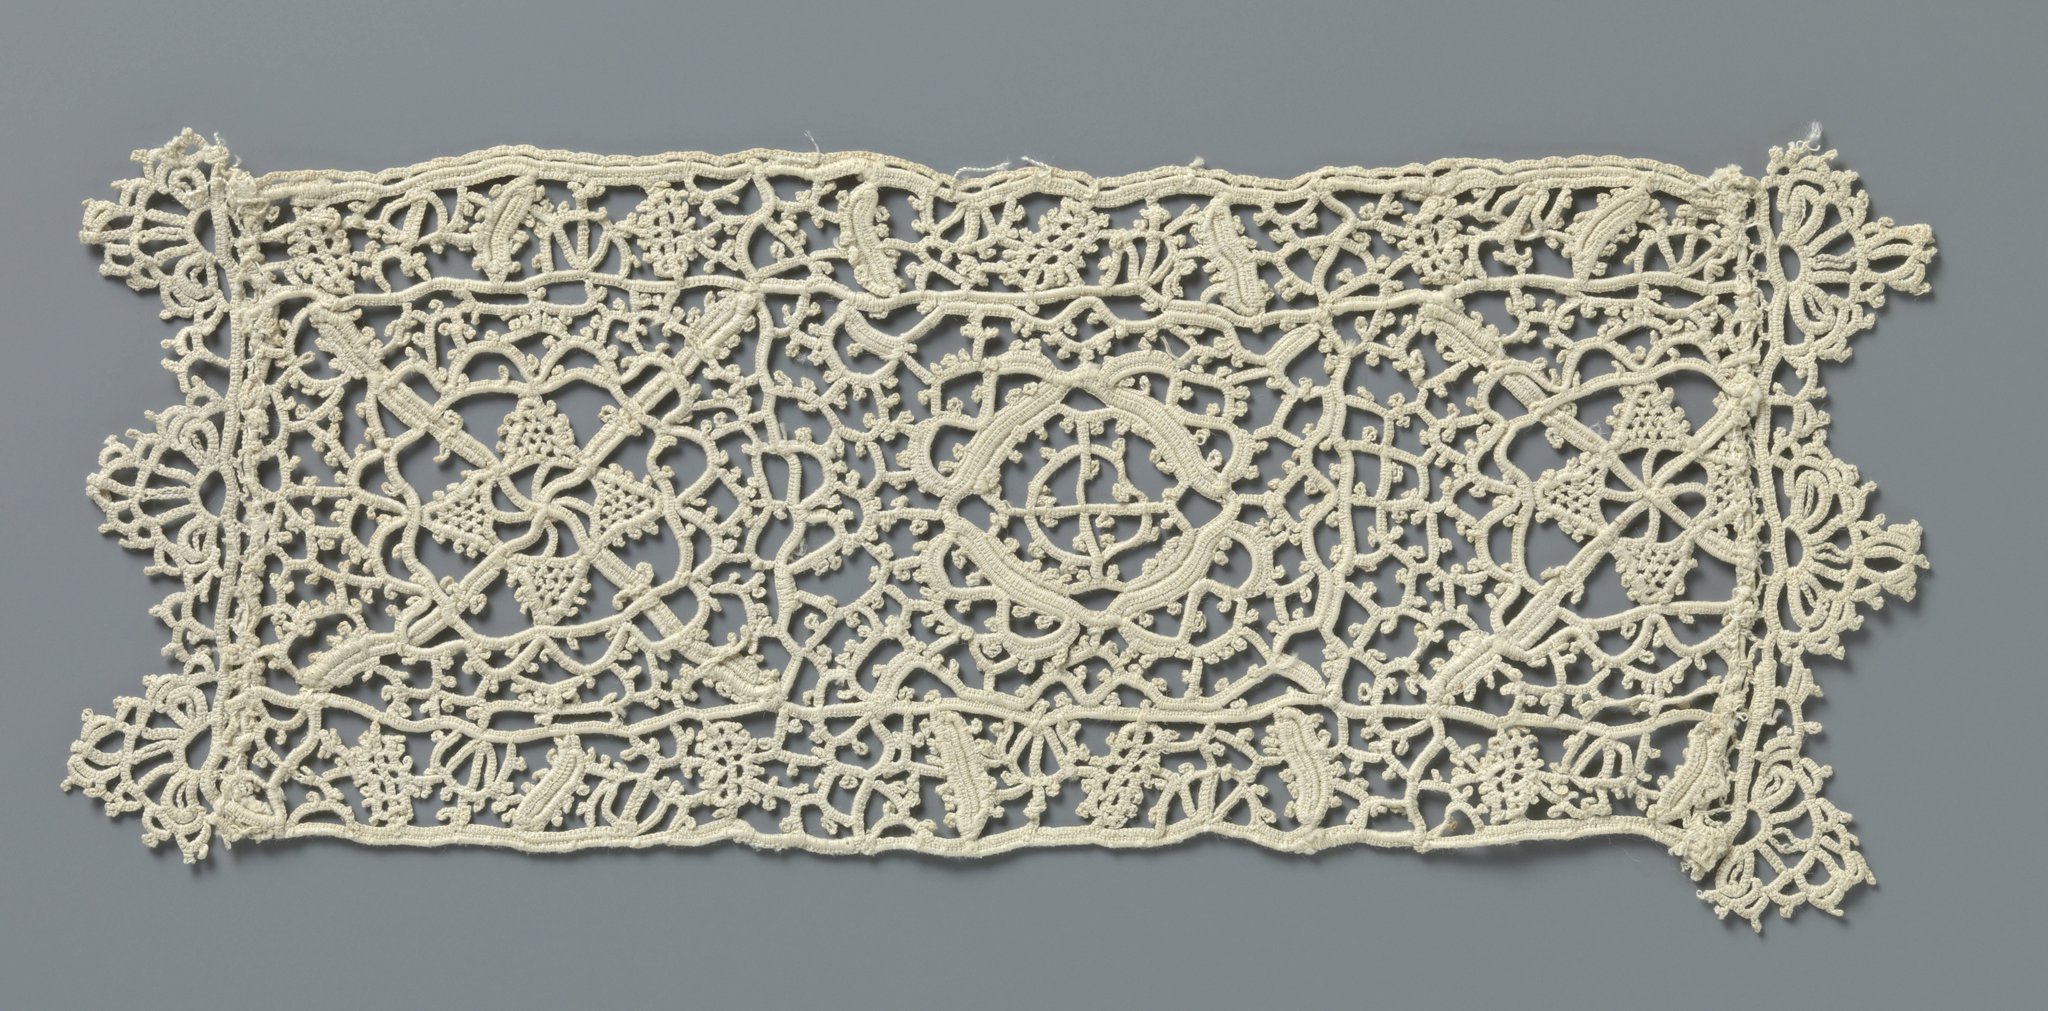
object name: strip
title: Strook gehaakte kant met reticella motieven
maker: Anonymous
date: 1890-1909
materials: cotton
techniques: crocheted lace, irish crochet lace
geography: ireland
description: Het is een aanname dat deze Ierse gehaakte kant ook daadwerkelijk in Ierland is gemaakt. Ierse gehaakte kant kent zijn oorsprong rond 1760 en kwam vanaf 1840 in ontwikkeling. Aangezien volgens Martine Bruggeman (Kant in Europa) de Ierse haakindustrie aan het eind van de 19e eeuw gereorganiseerd werd en in populariteit groeide, is het hier beschreven stuk gedateerd rond 1890, tot 1909 vanwege de datering in het eerste decennium van populariteit van Ierse gehaakte kant volgens het Kantlexicon (Johan Coene).